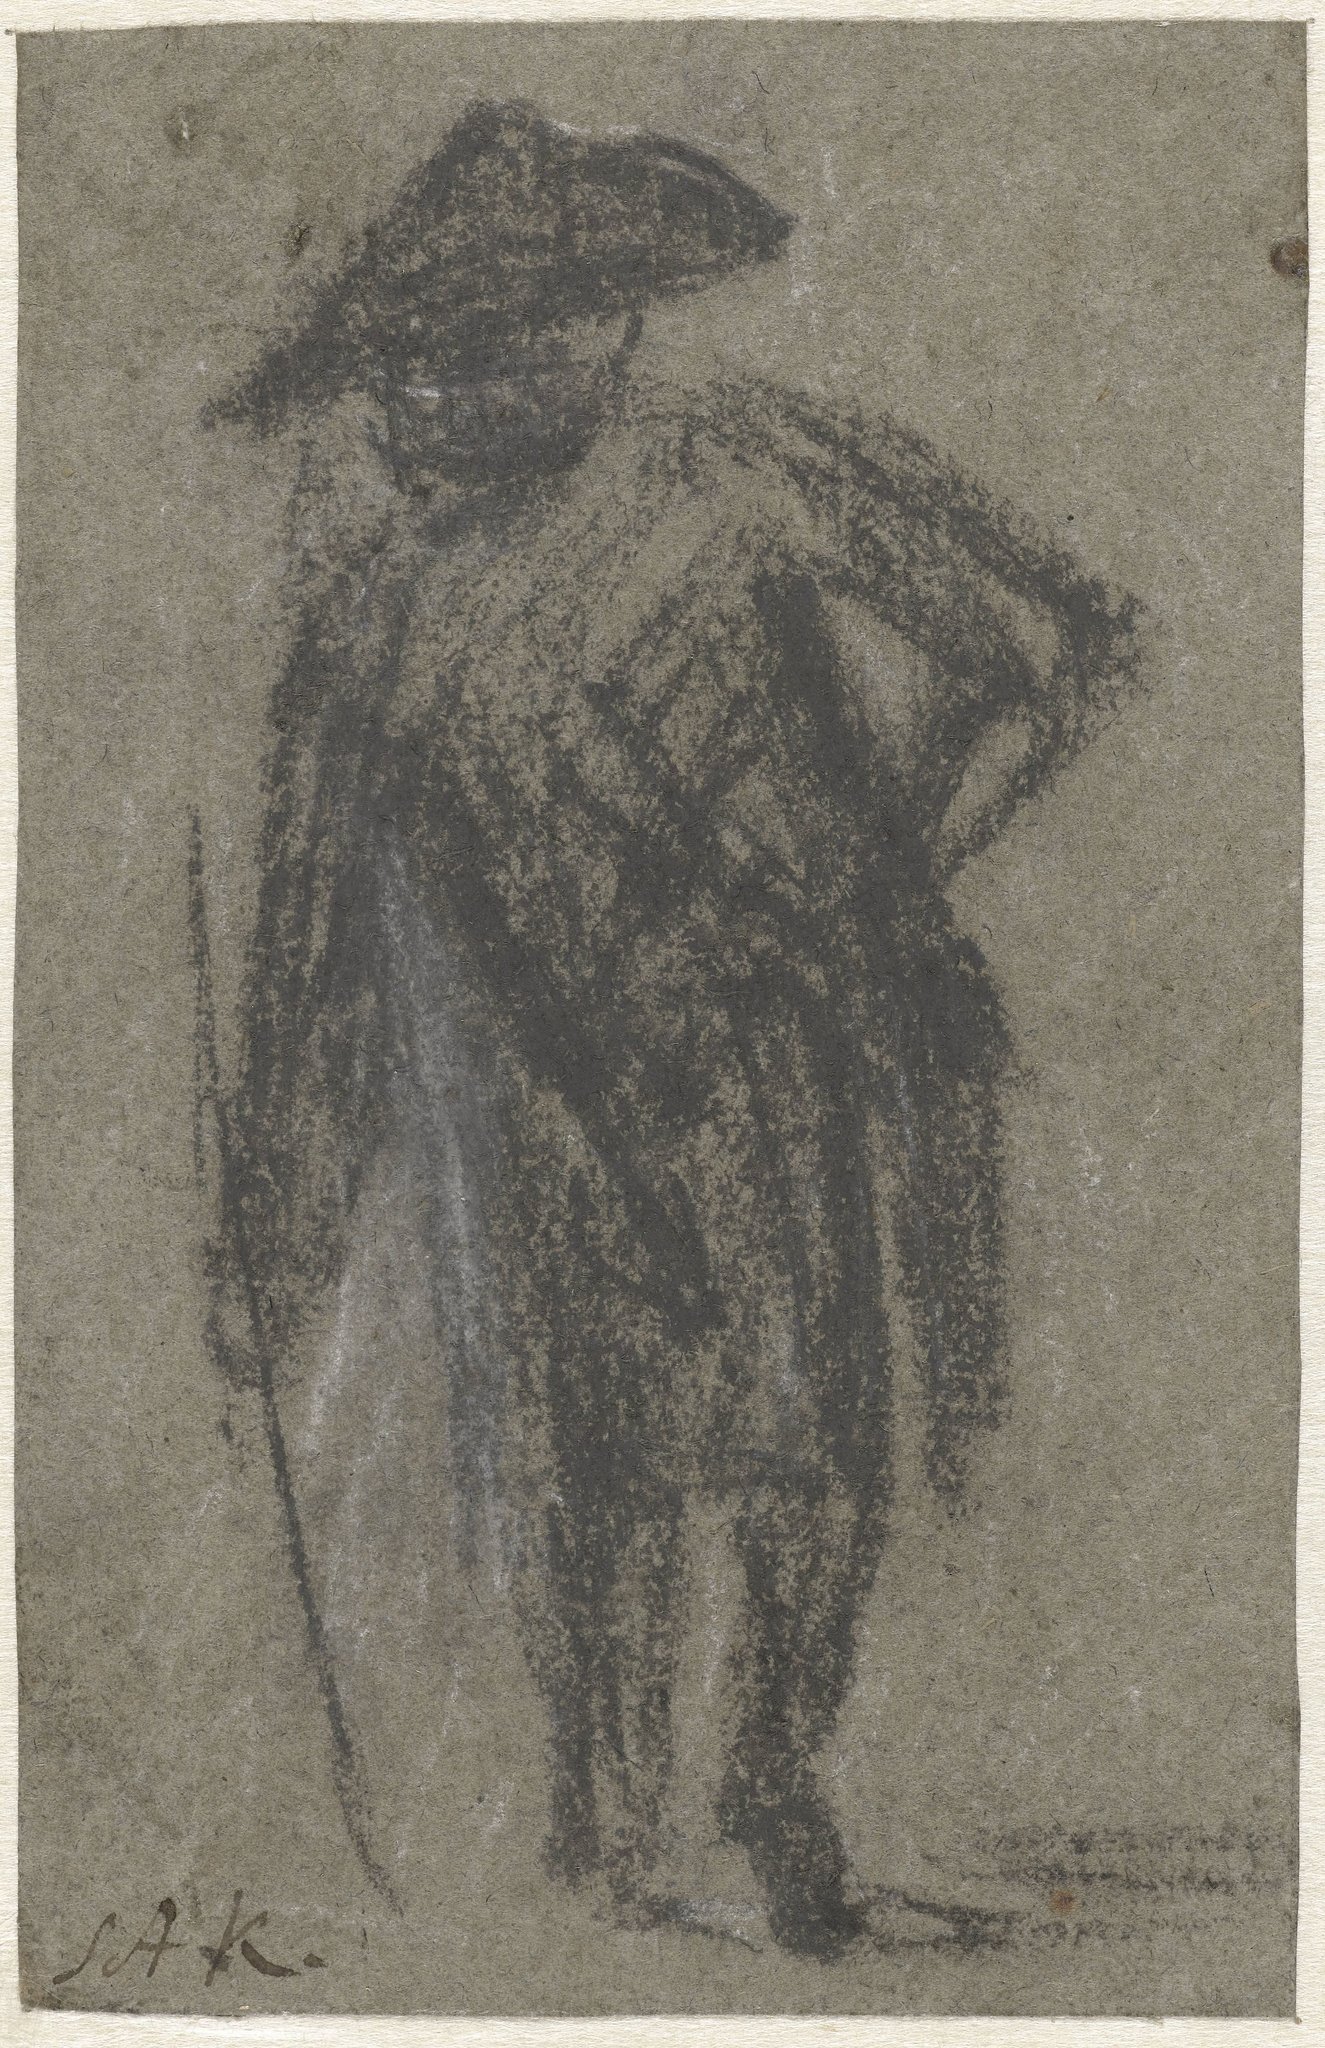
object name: drawing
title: Karikatuur van een man met een kromme rug, op de rug gezien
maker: simon andreas krausz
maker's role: draughtsman, print maker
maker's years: 1760-1825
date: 1770-1825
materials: chalk, paper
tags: caricatures (human types)